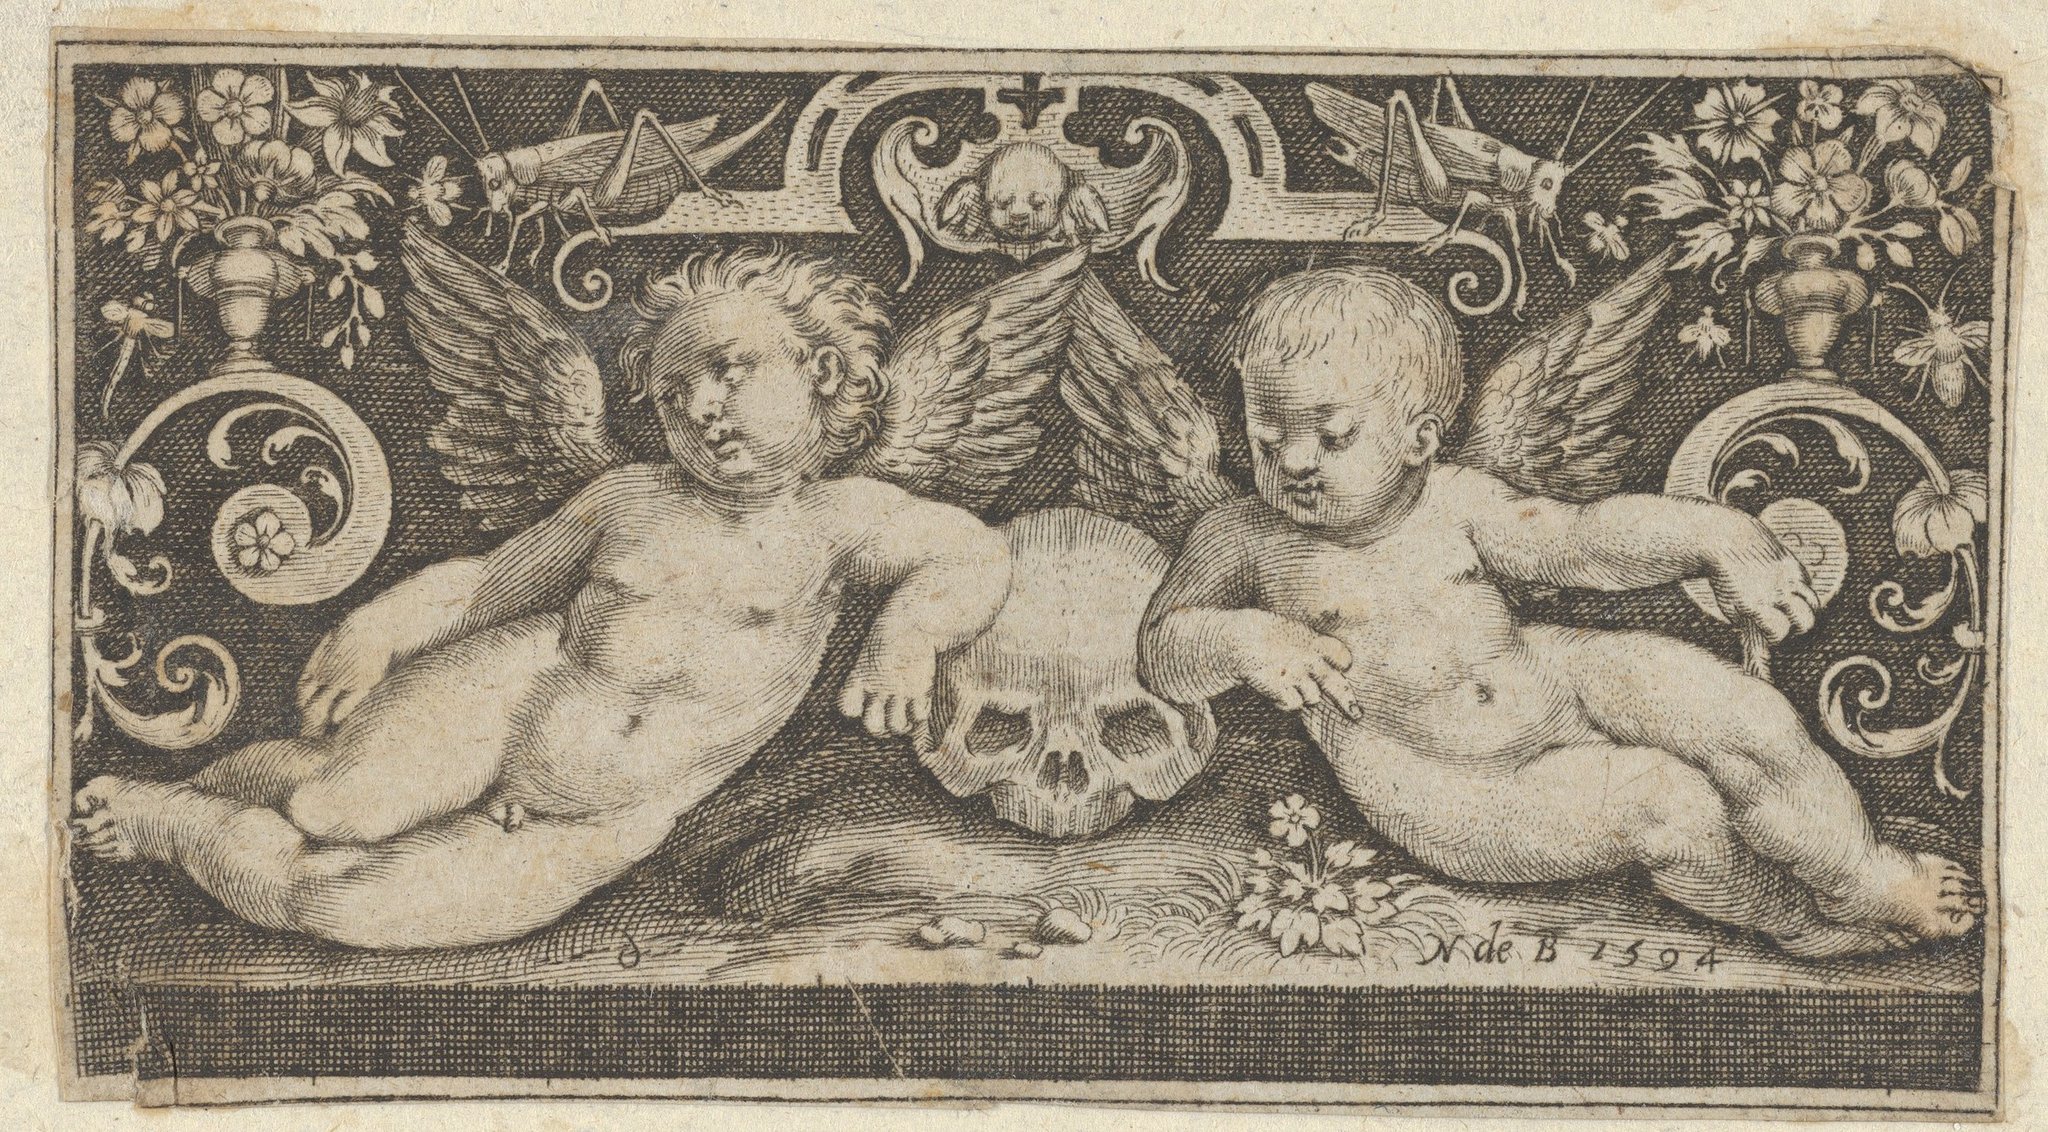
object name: print ornament architecture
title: Two Genii with a Skull and Grasshoppers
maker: nicolaes de bruyn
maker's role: artist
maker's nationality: netherlandish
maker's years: 1571-1656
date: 1594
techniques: engraving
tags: insects,vases